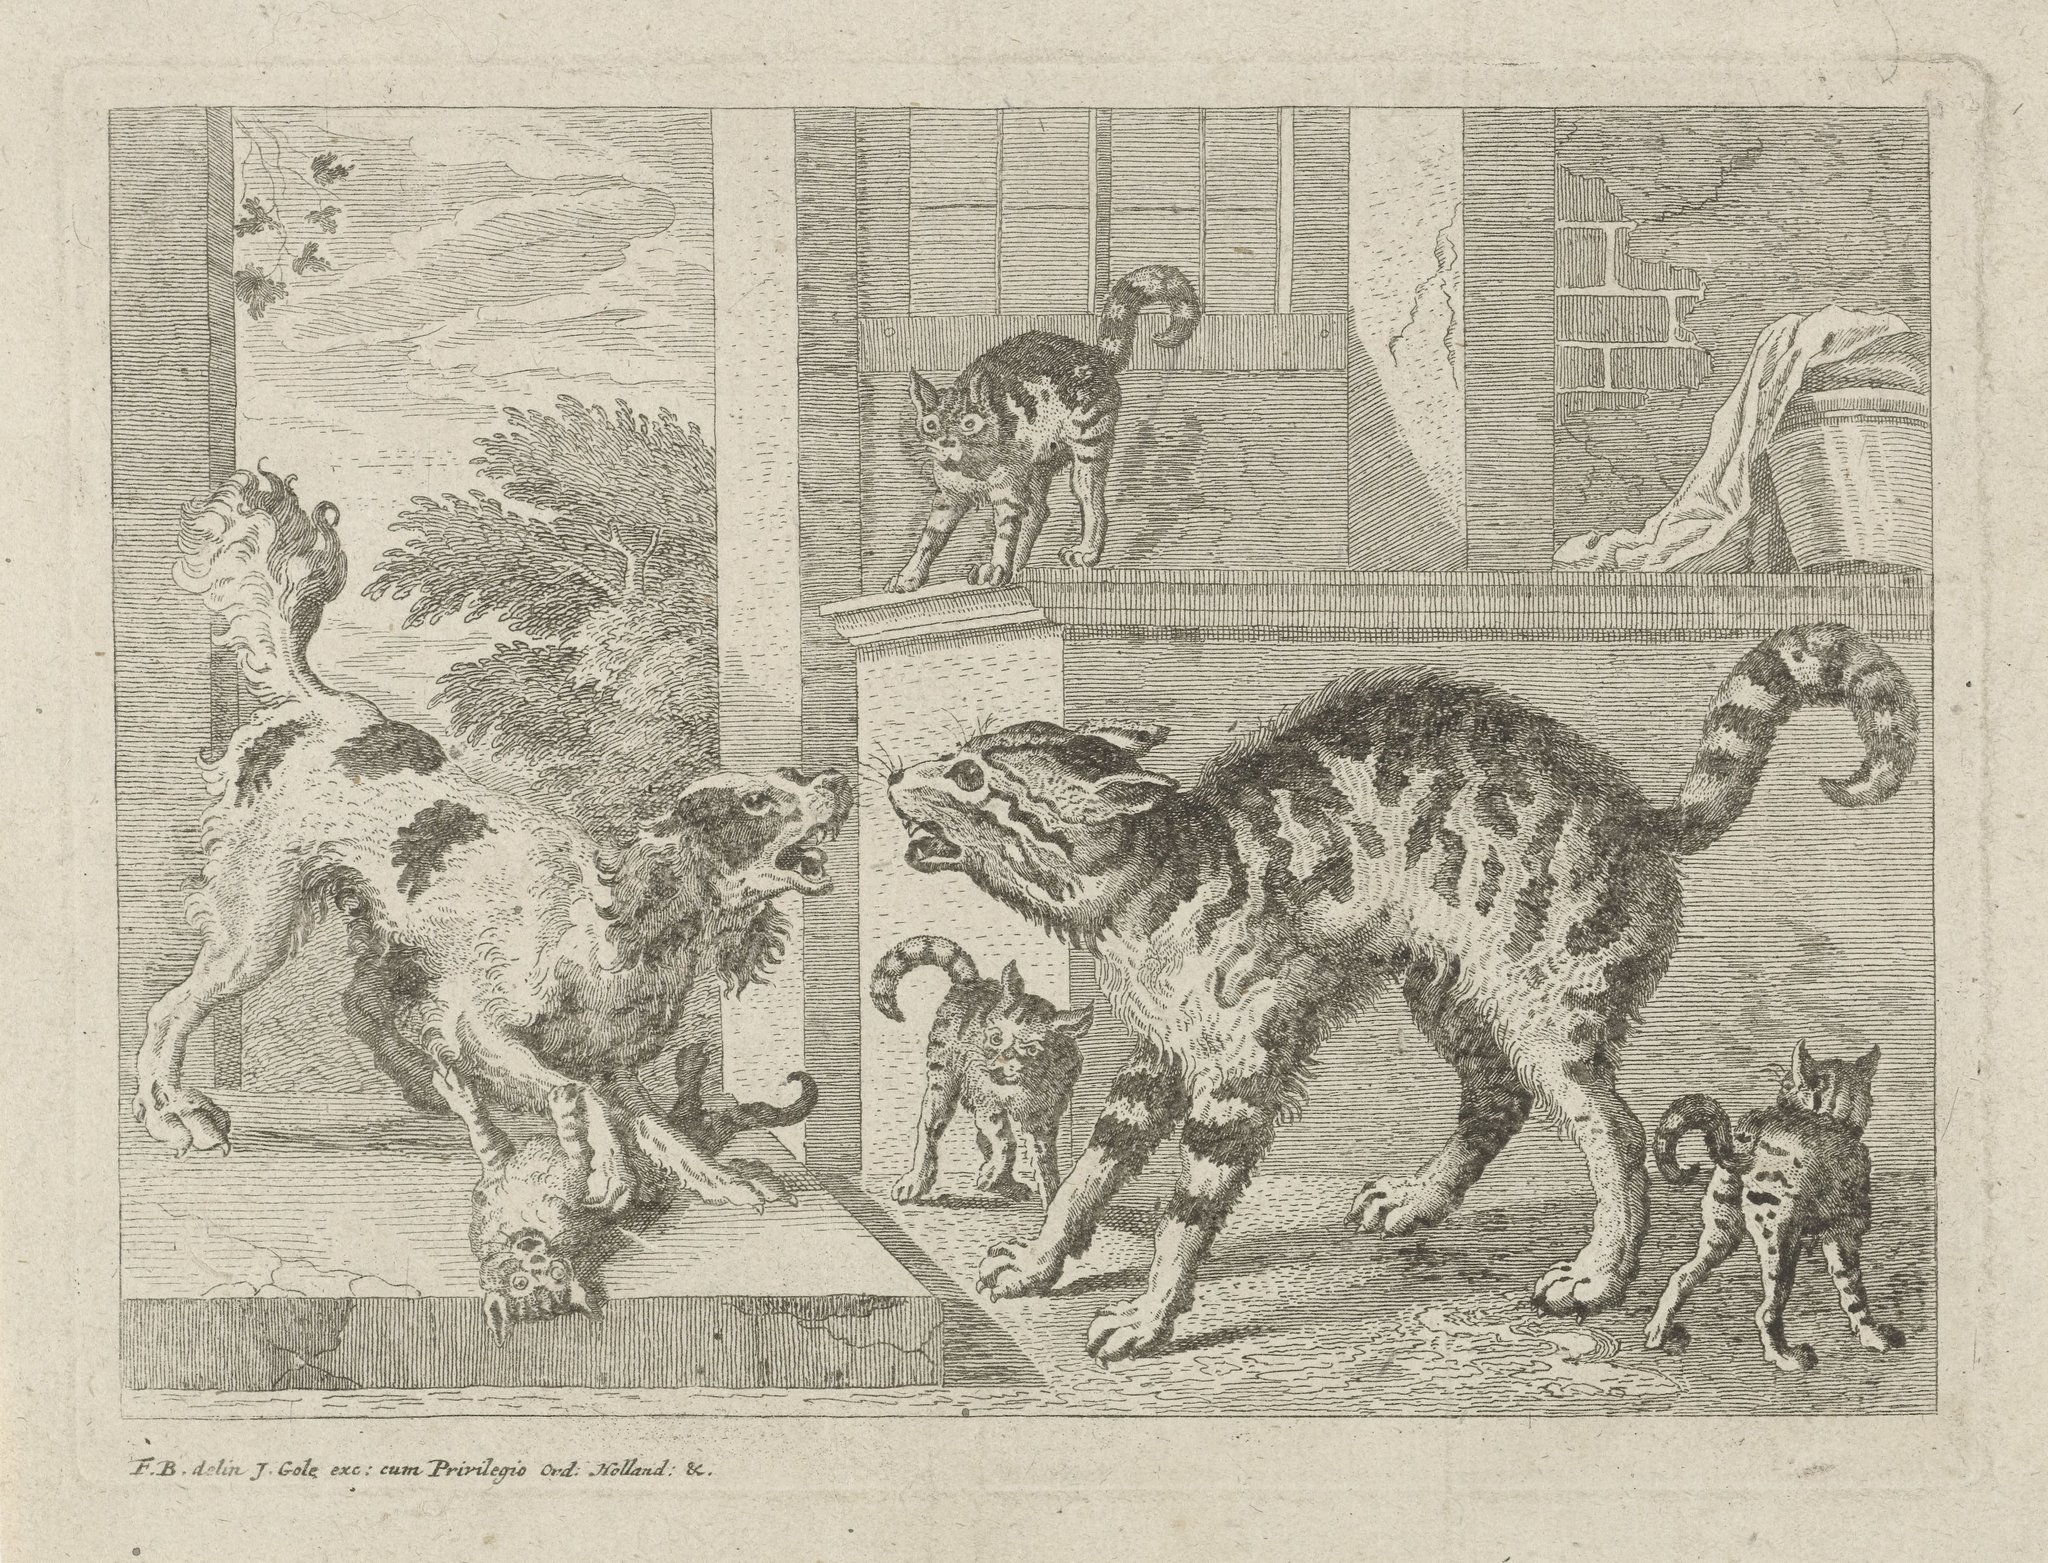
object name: print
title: Kat verdedigt haar jongen tegenover een hond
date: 1680-1723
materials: paper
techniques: etching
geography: amsterdam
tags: cat, dog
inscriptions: collector's mark: Lugt 2228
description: Een hond heeft een jong katje aangevallen. Zijn moeder komt te hulp en verdedigt haar jongen door een hoge rug op te zetten. Rondom haar drie andere kittens. De prent maakt deel uit van een serie met verschillende dieren als onderwerp.